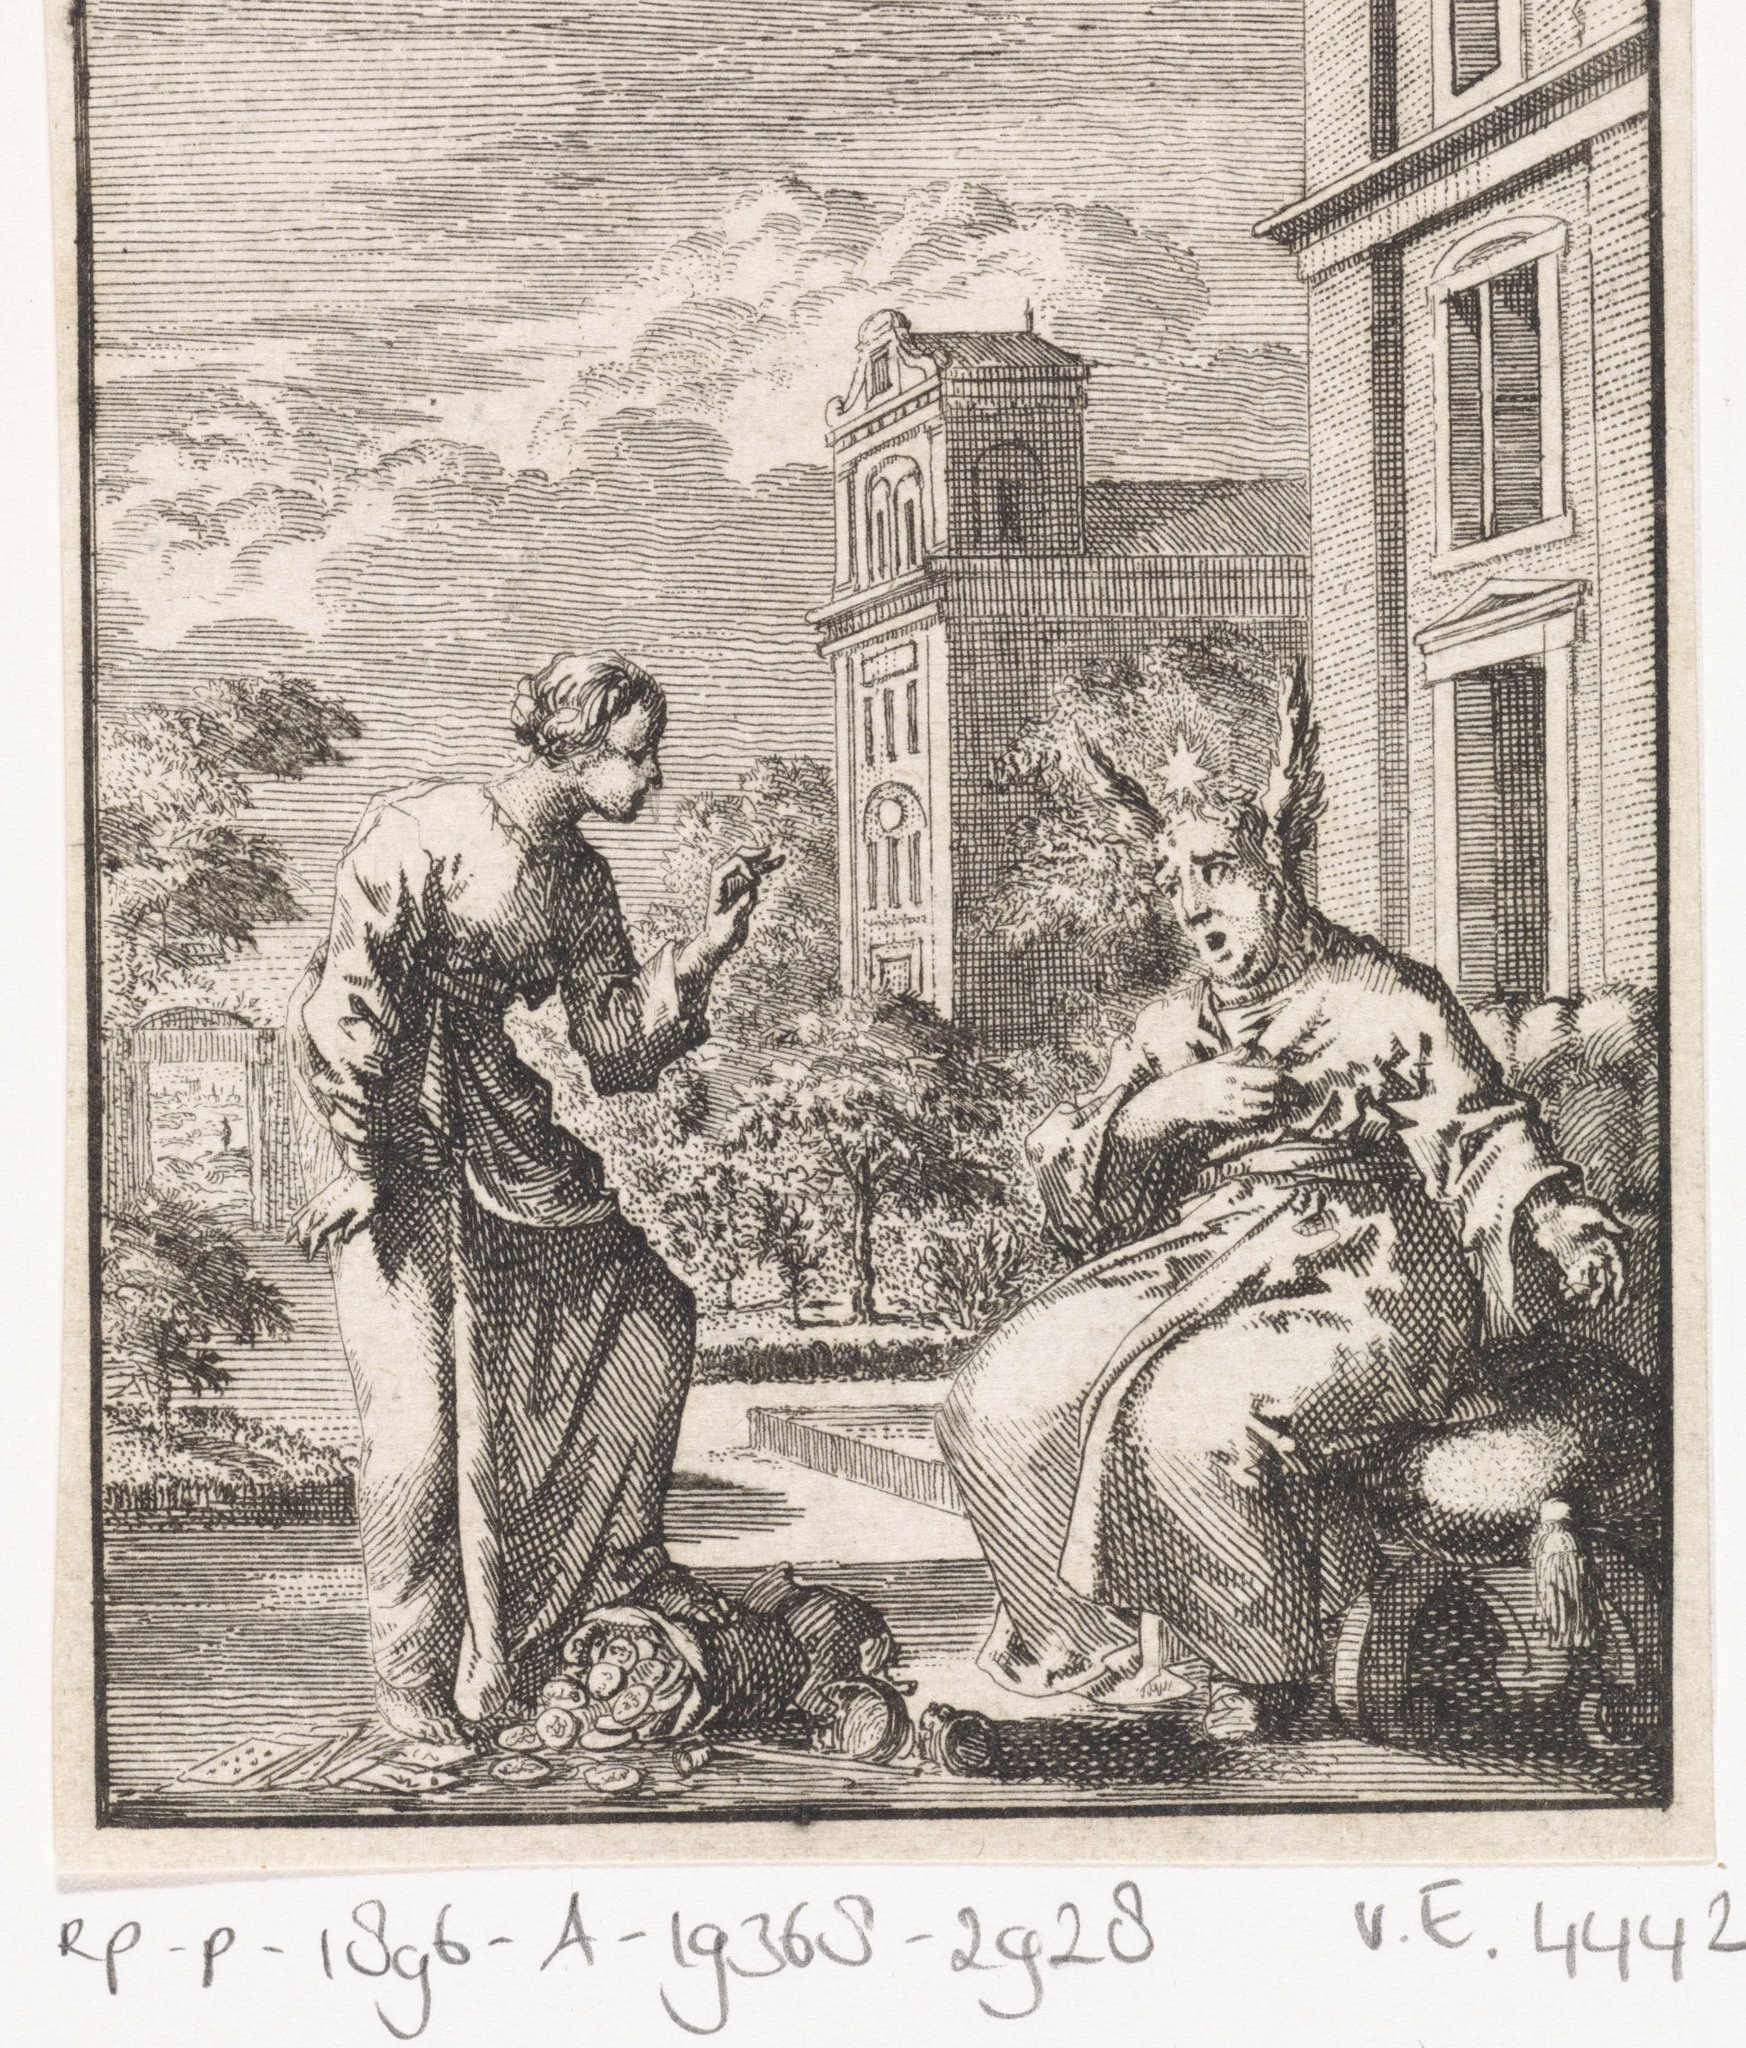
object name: print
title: De Ziel wederspreekt het Vleesch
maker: jan luyken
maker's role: draughtsman, print maker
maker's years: 1649-1712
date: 1714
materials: paper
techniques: etching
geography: amsterdam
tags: spirit (or soul) versus body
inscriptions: collector's mark: Lugt 2228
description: De gepersonifieerde ziel spreekt de personificatie van het Vlees (wereldse verlokkingen) tegen. Onder haar voeten liggen spelkaarten, een stokkenbeurs, munten en andere voorwerpen die symbool staan voor een zondig leven.